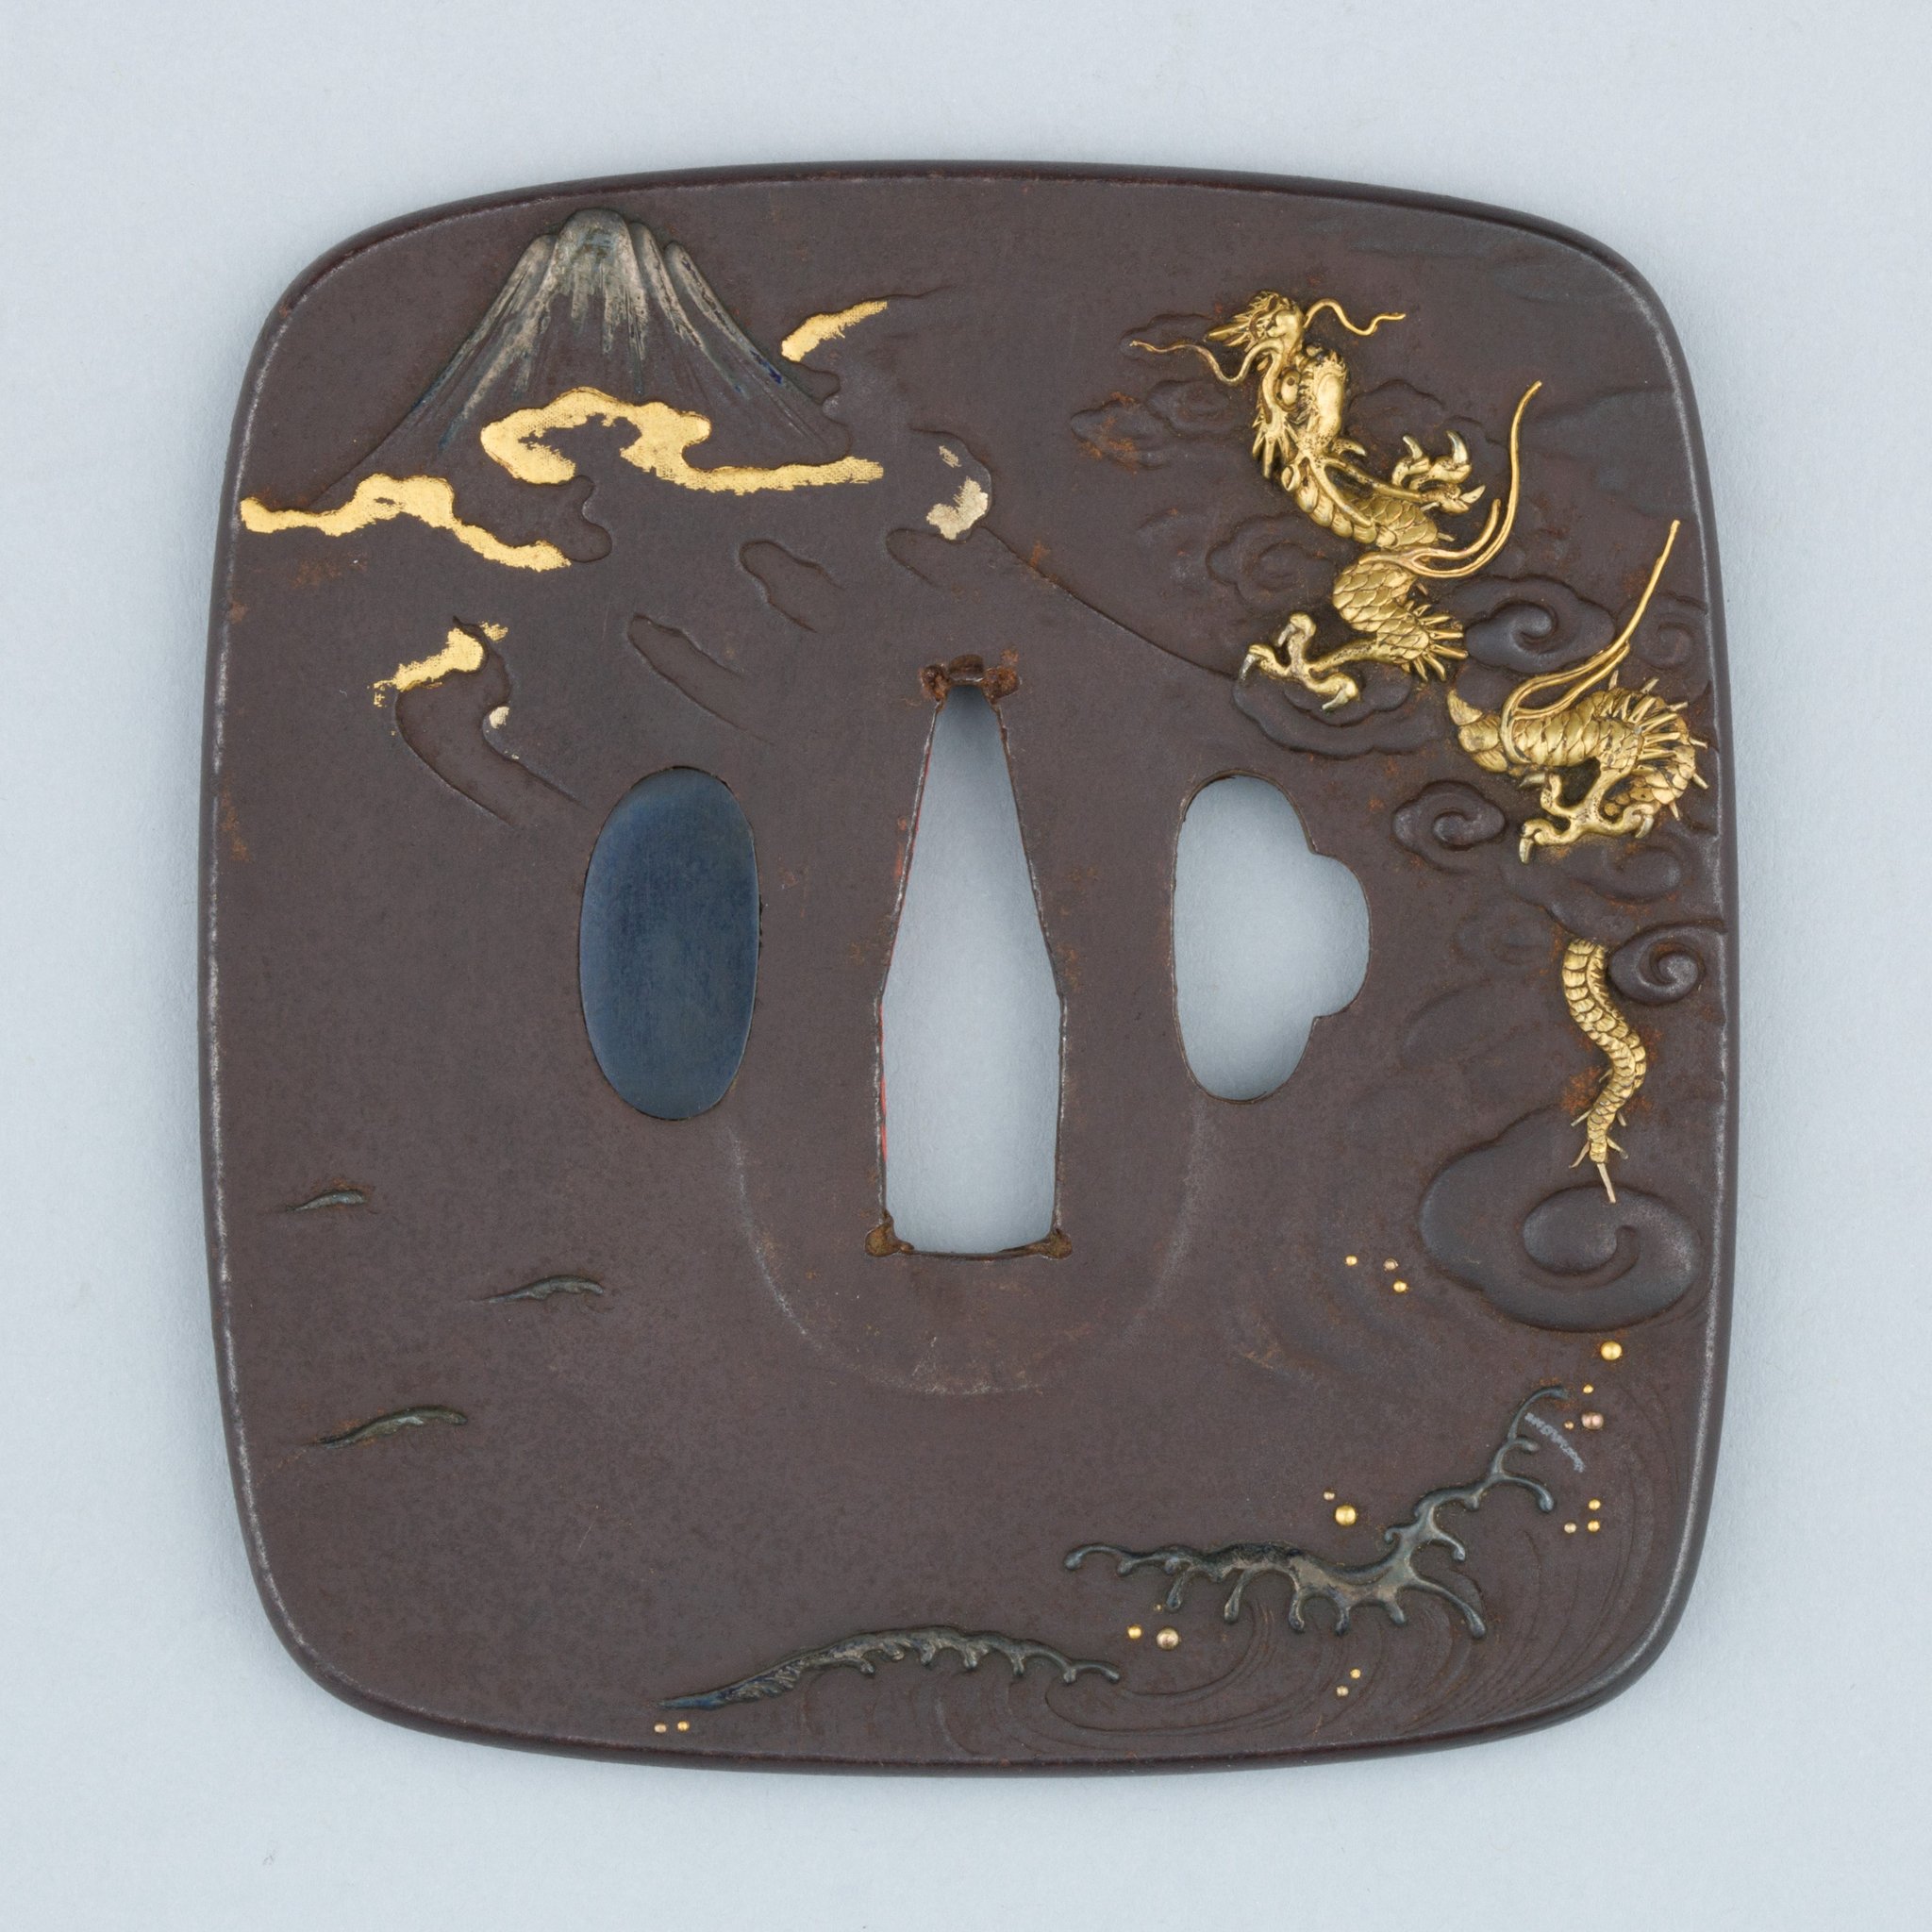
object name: sword guard tsuba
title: Sword Guard (Tsuba)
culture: japanese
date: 1615-1868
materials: copper, gold, iron, silver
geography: japan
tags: dragons,mountains